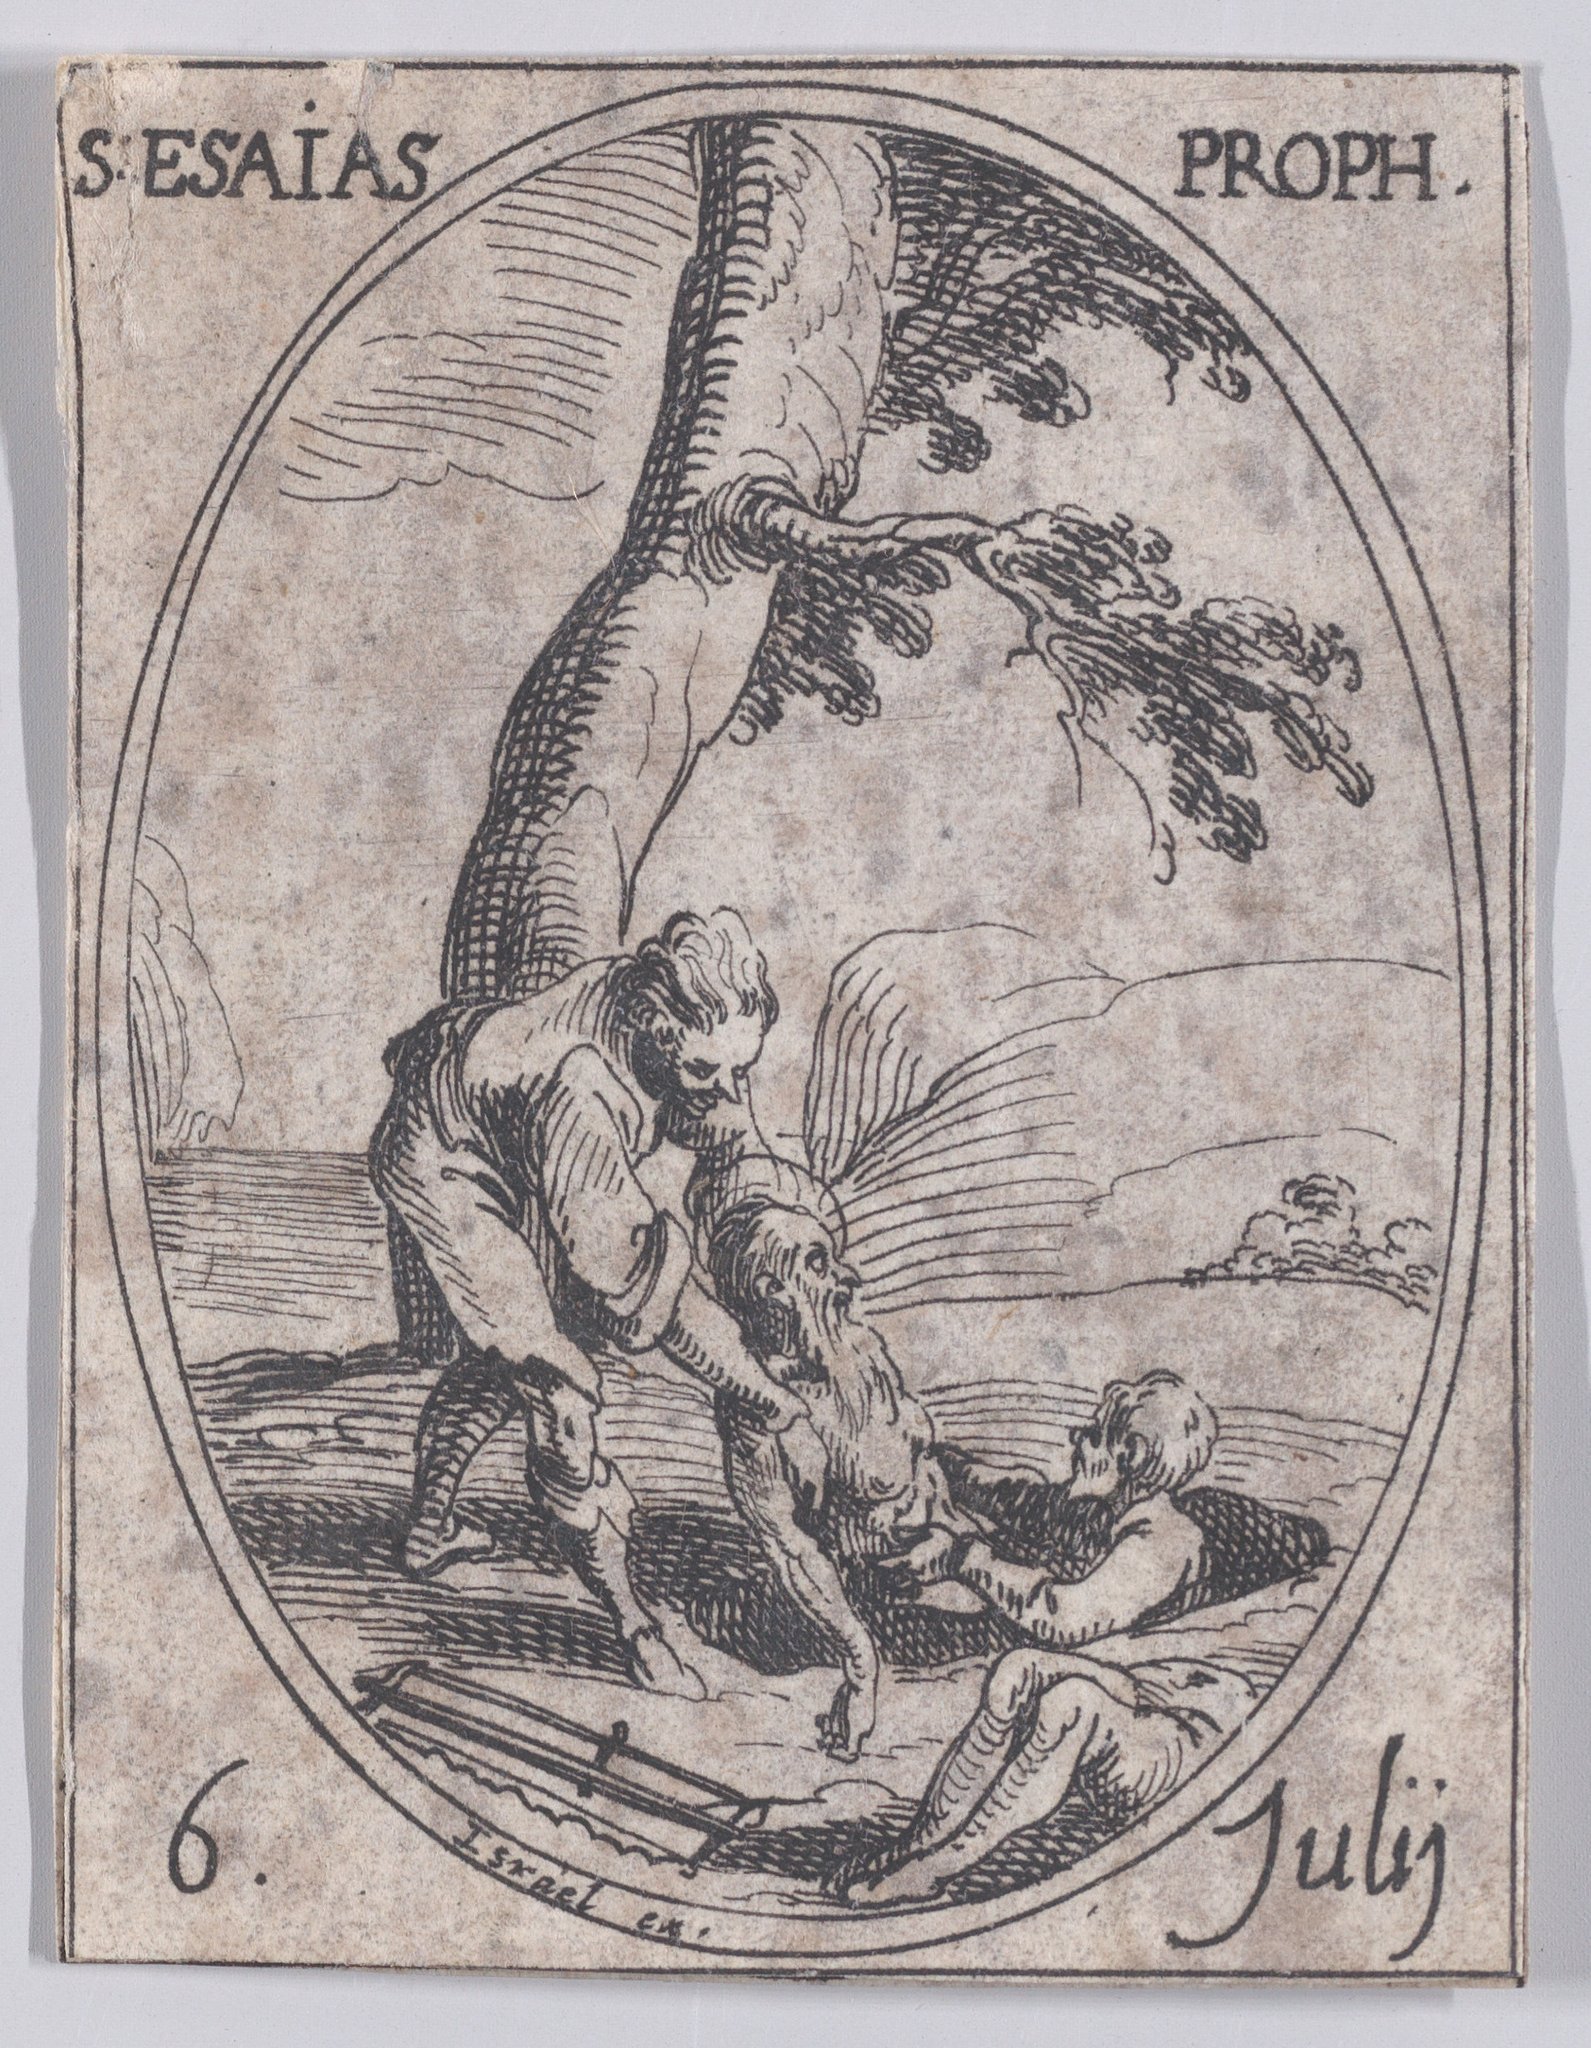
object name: print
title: S. Esaü, prophète (St. Isaiah, Prophet), July 6th, from "Les Images De Tous Les Saincts et Saintes de L'Année" (Images of All of the Saints and Religious Events of the Year)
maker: jacques callot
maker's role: artist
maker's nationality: french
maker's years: 1592-1635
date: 1636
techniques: etching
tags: men,saints